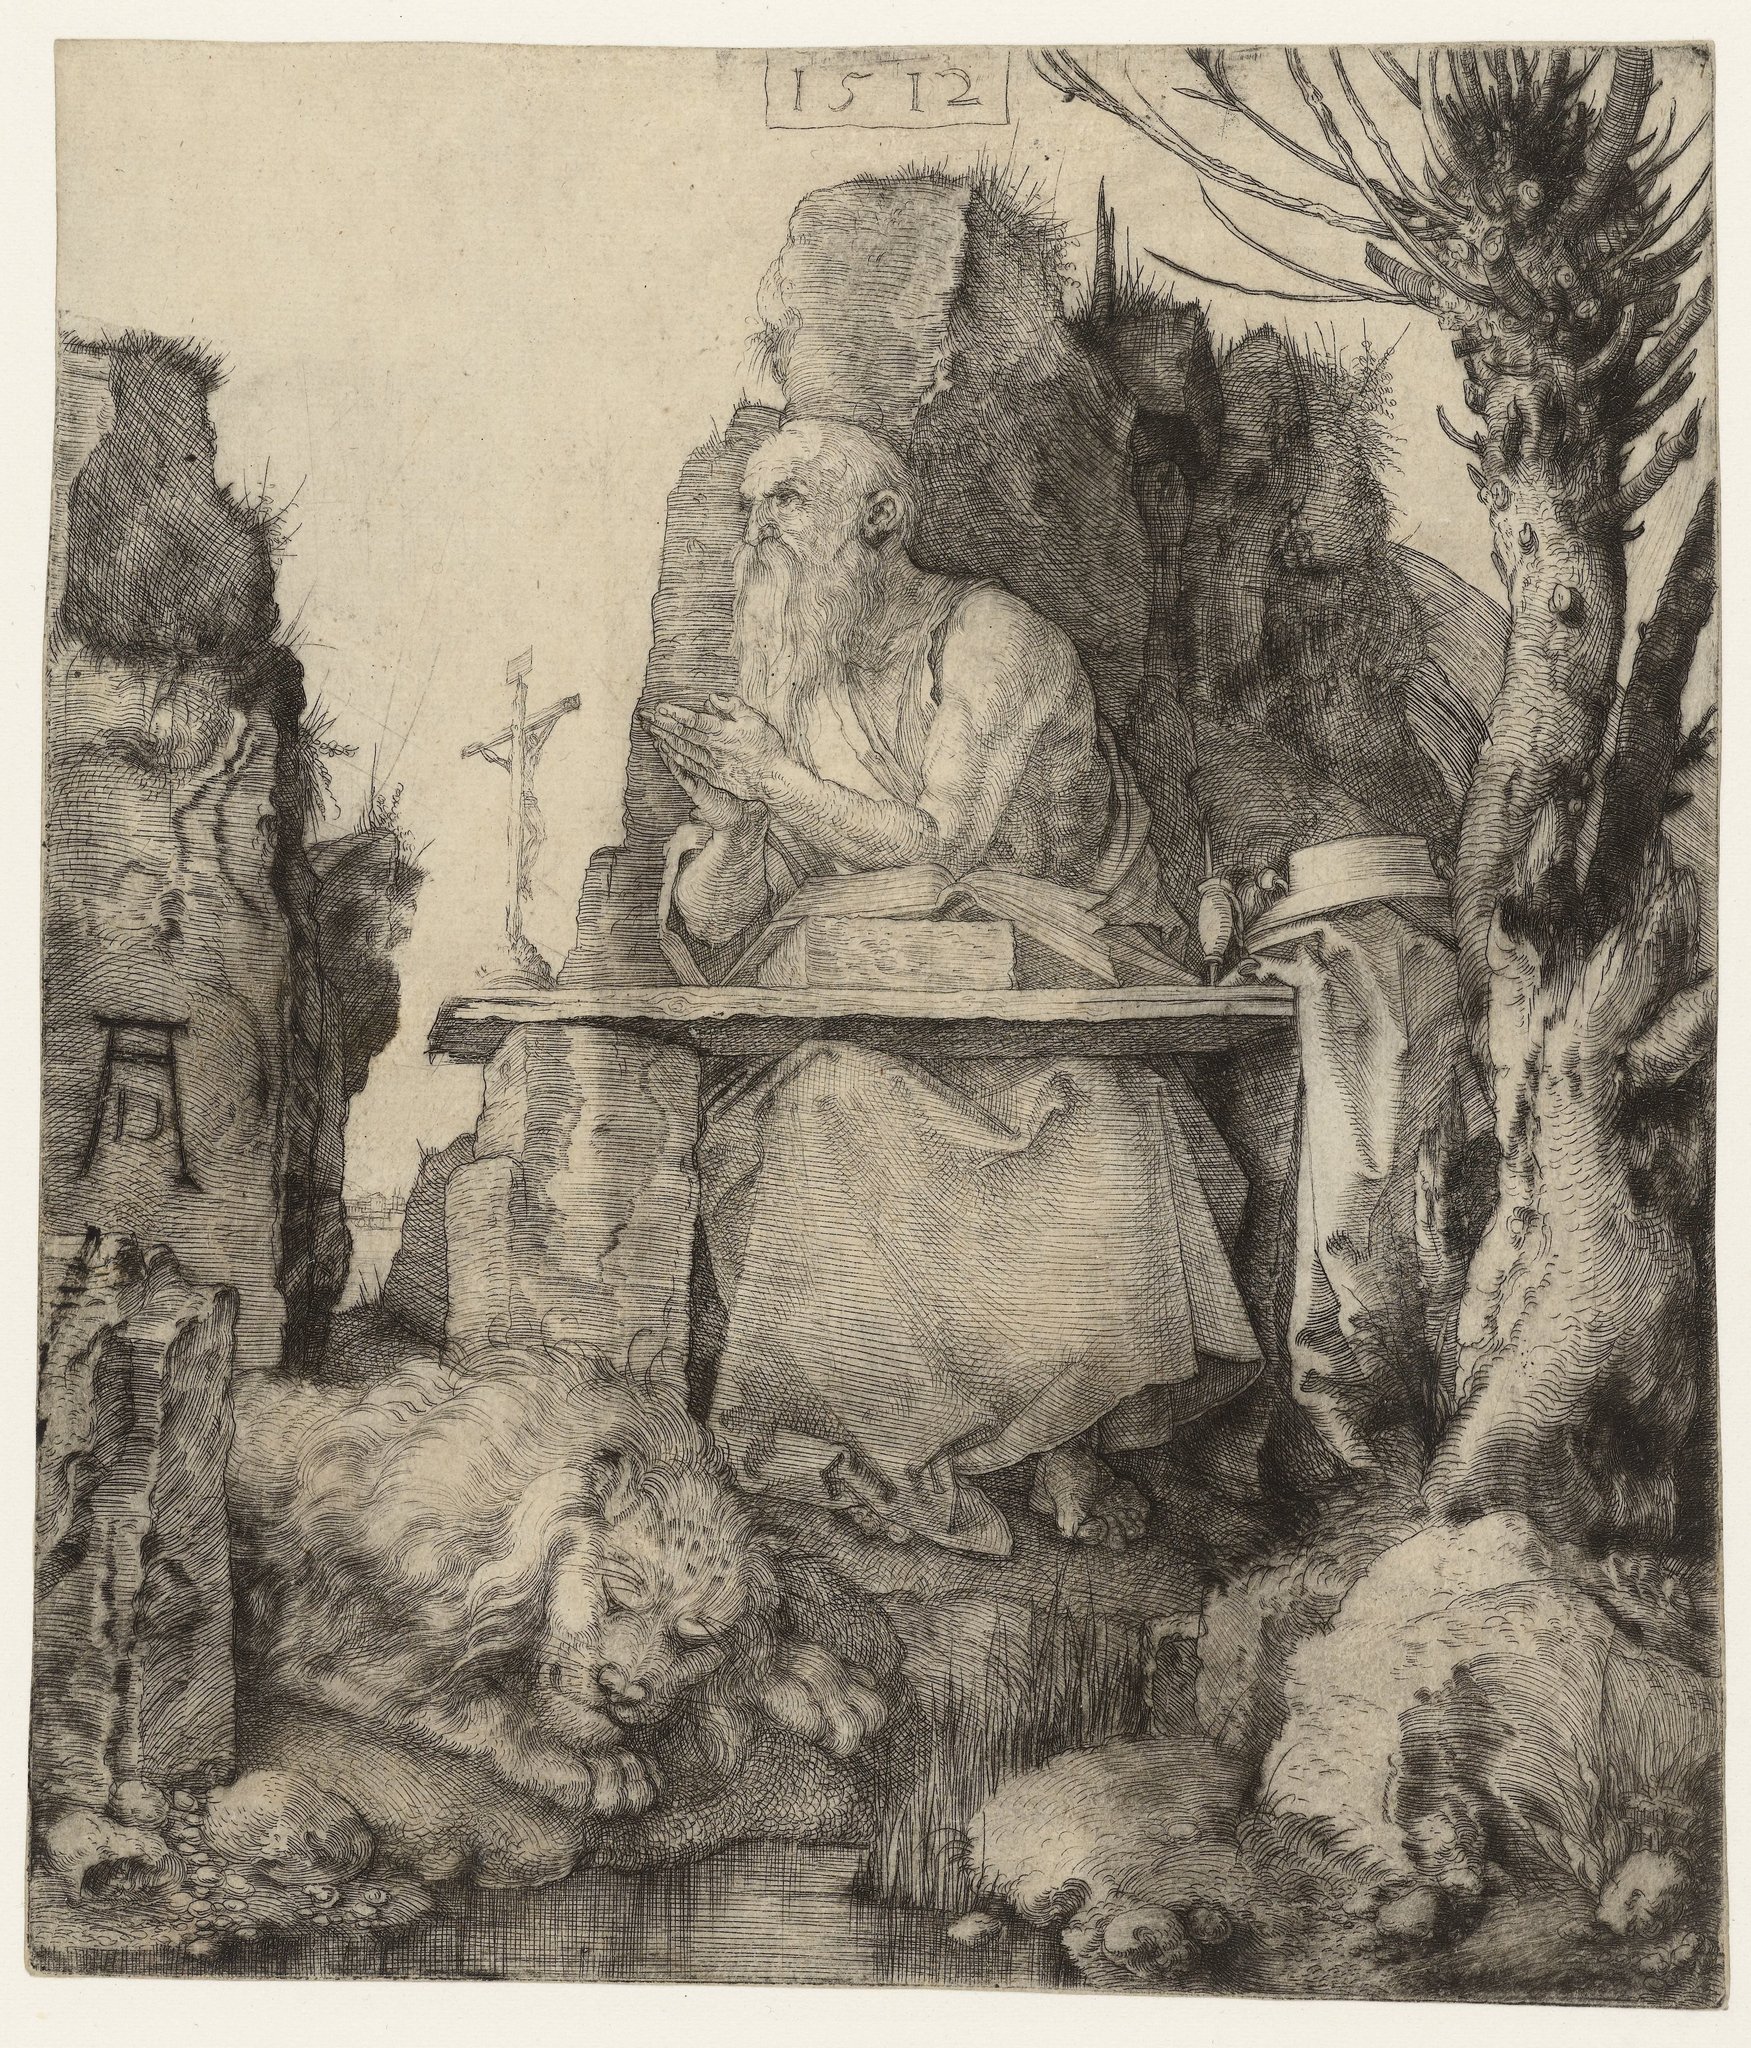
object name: print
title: St Jerome in the Wilderness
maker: albrecht dürer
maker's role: draughtsman, painter, print maker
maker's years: 1471-1528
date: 1512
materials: paper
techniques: drypoint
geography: nuremberg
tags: st. jerome as hermit in a landscape, reading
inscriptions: collector's mark: Lugt 2773, collector's mark: Lugt 119, collector's mark: ‘F...’, collector's mark: Lugt 2228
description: This depiction was made by incising lines directly into a metal plate with an etching needle. This technique yields only a small number of perfect impressions. The St Jerome was therefore considered a rarity even in Dürer’s own lifetime. To meet demand for it, publishers brought copies on the market: at least five different copies of this print are known.